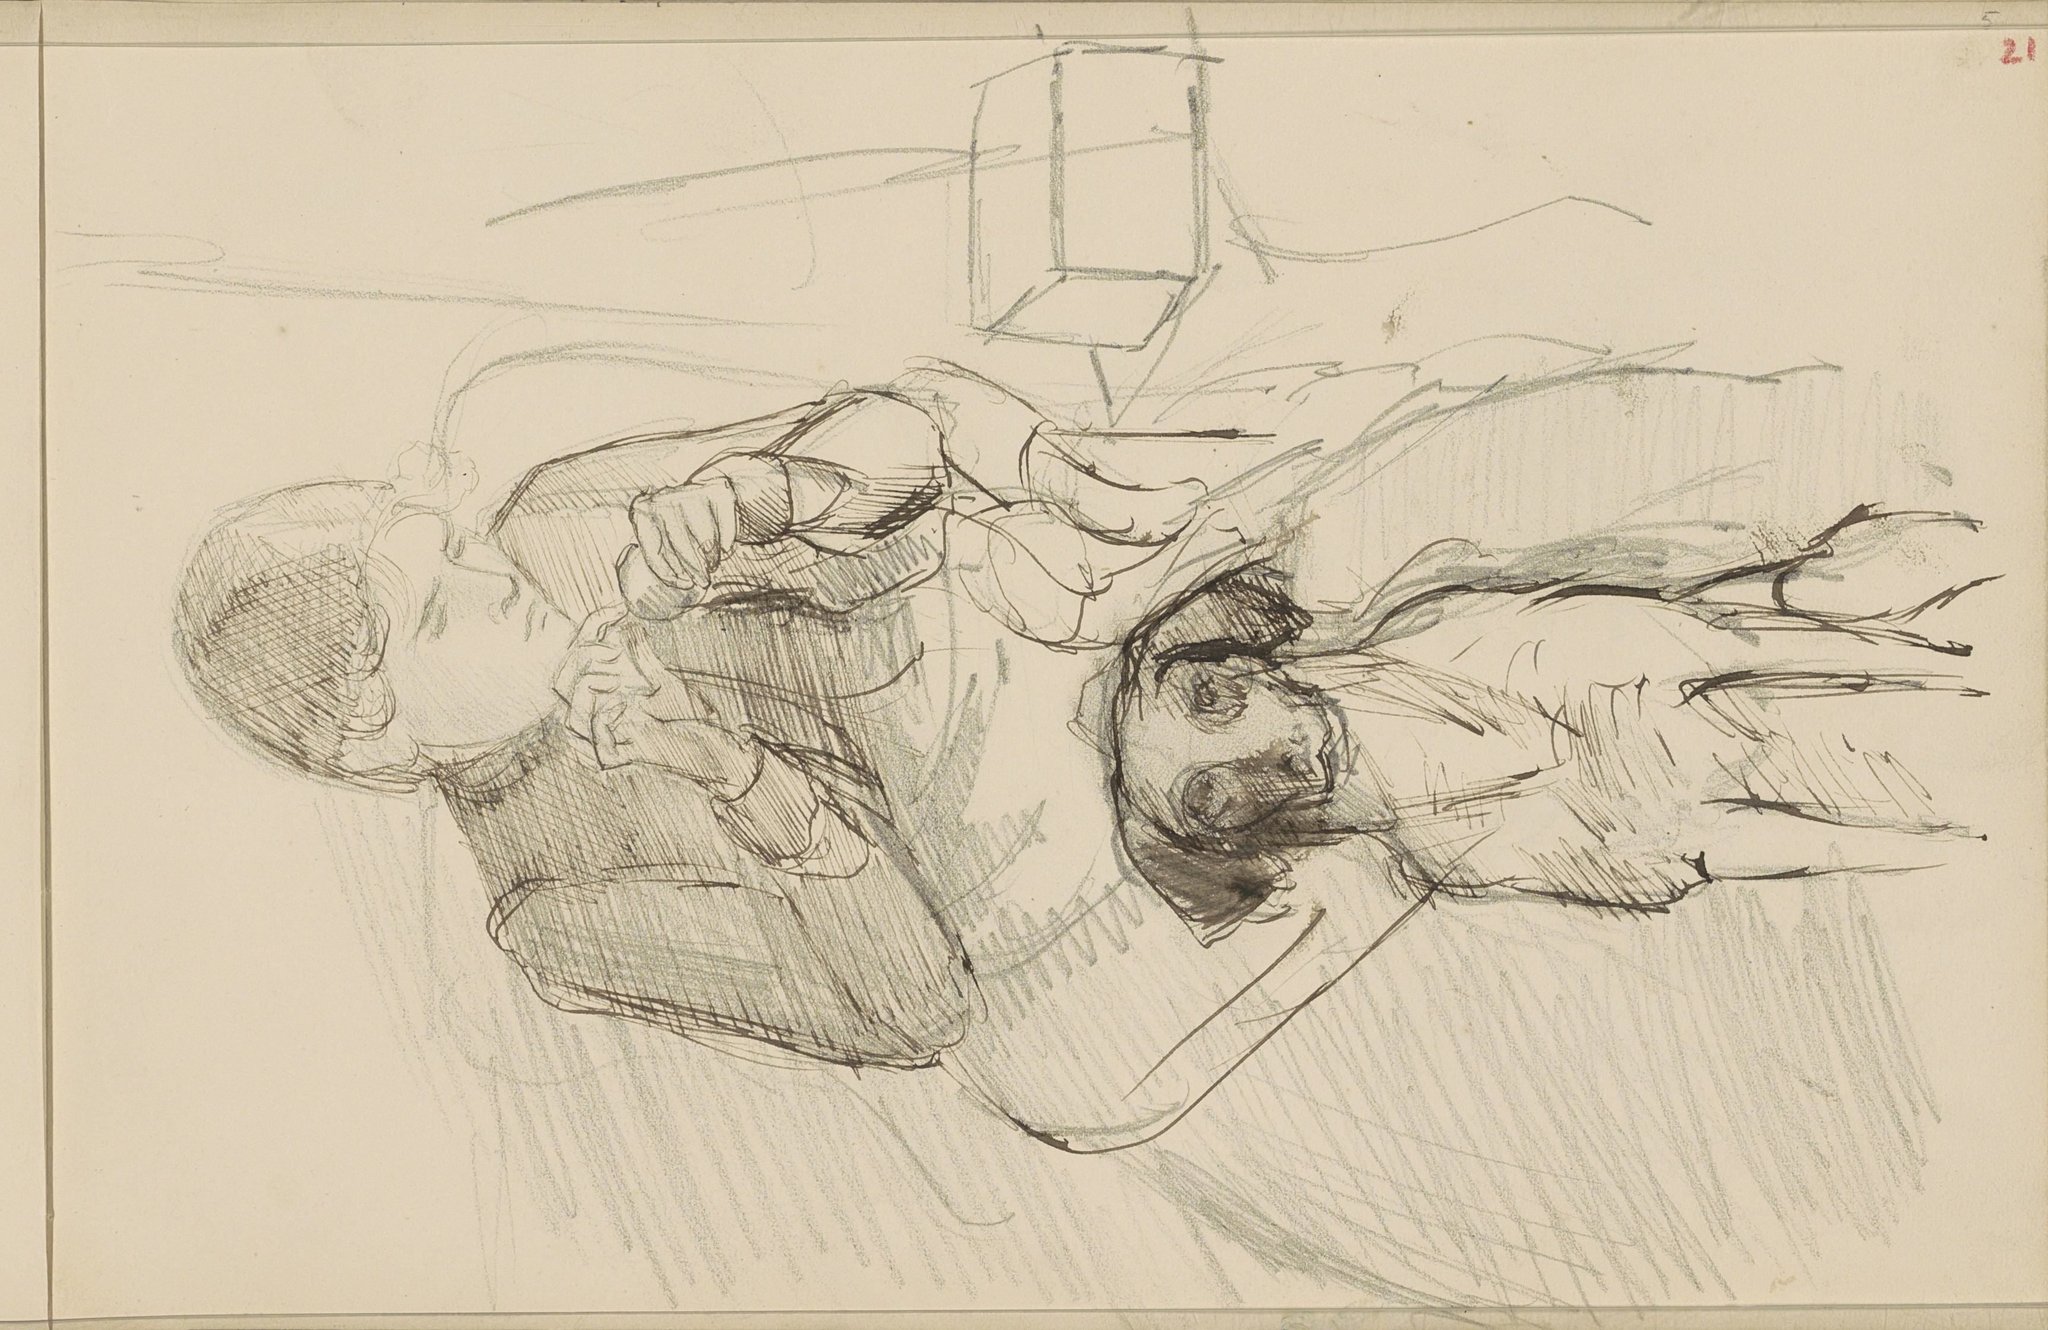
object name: sketchbook leaf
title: Hond zittend bij een vrouw in een stoel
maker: jozef israëls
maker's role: draughtsman, painter, print maker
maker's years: 1824-1911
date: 1834-1911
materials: ink, paper, pencil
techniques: pen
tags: sitting figure - aa - female human figure, dog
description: De vrouw heeft een voorwerp in haar handen. Naast haar staat een doos op tafel, mogelijk een naaidoos. Blad 5 recto uit een schetsboek met 25 bladen.